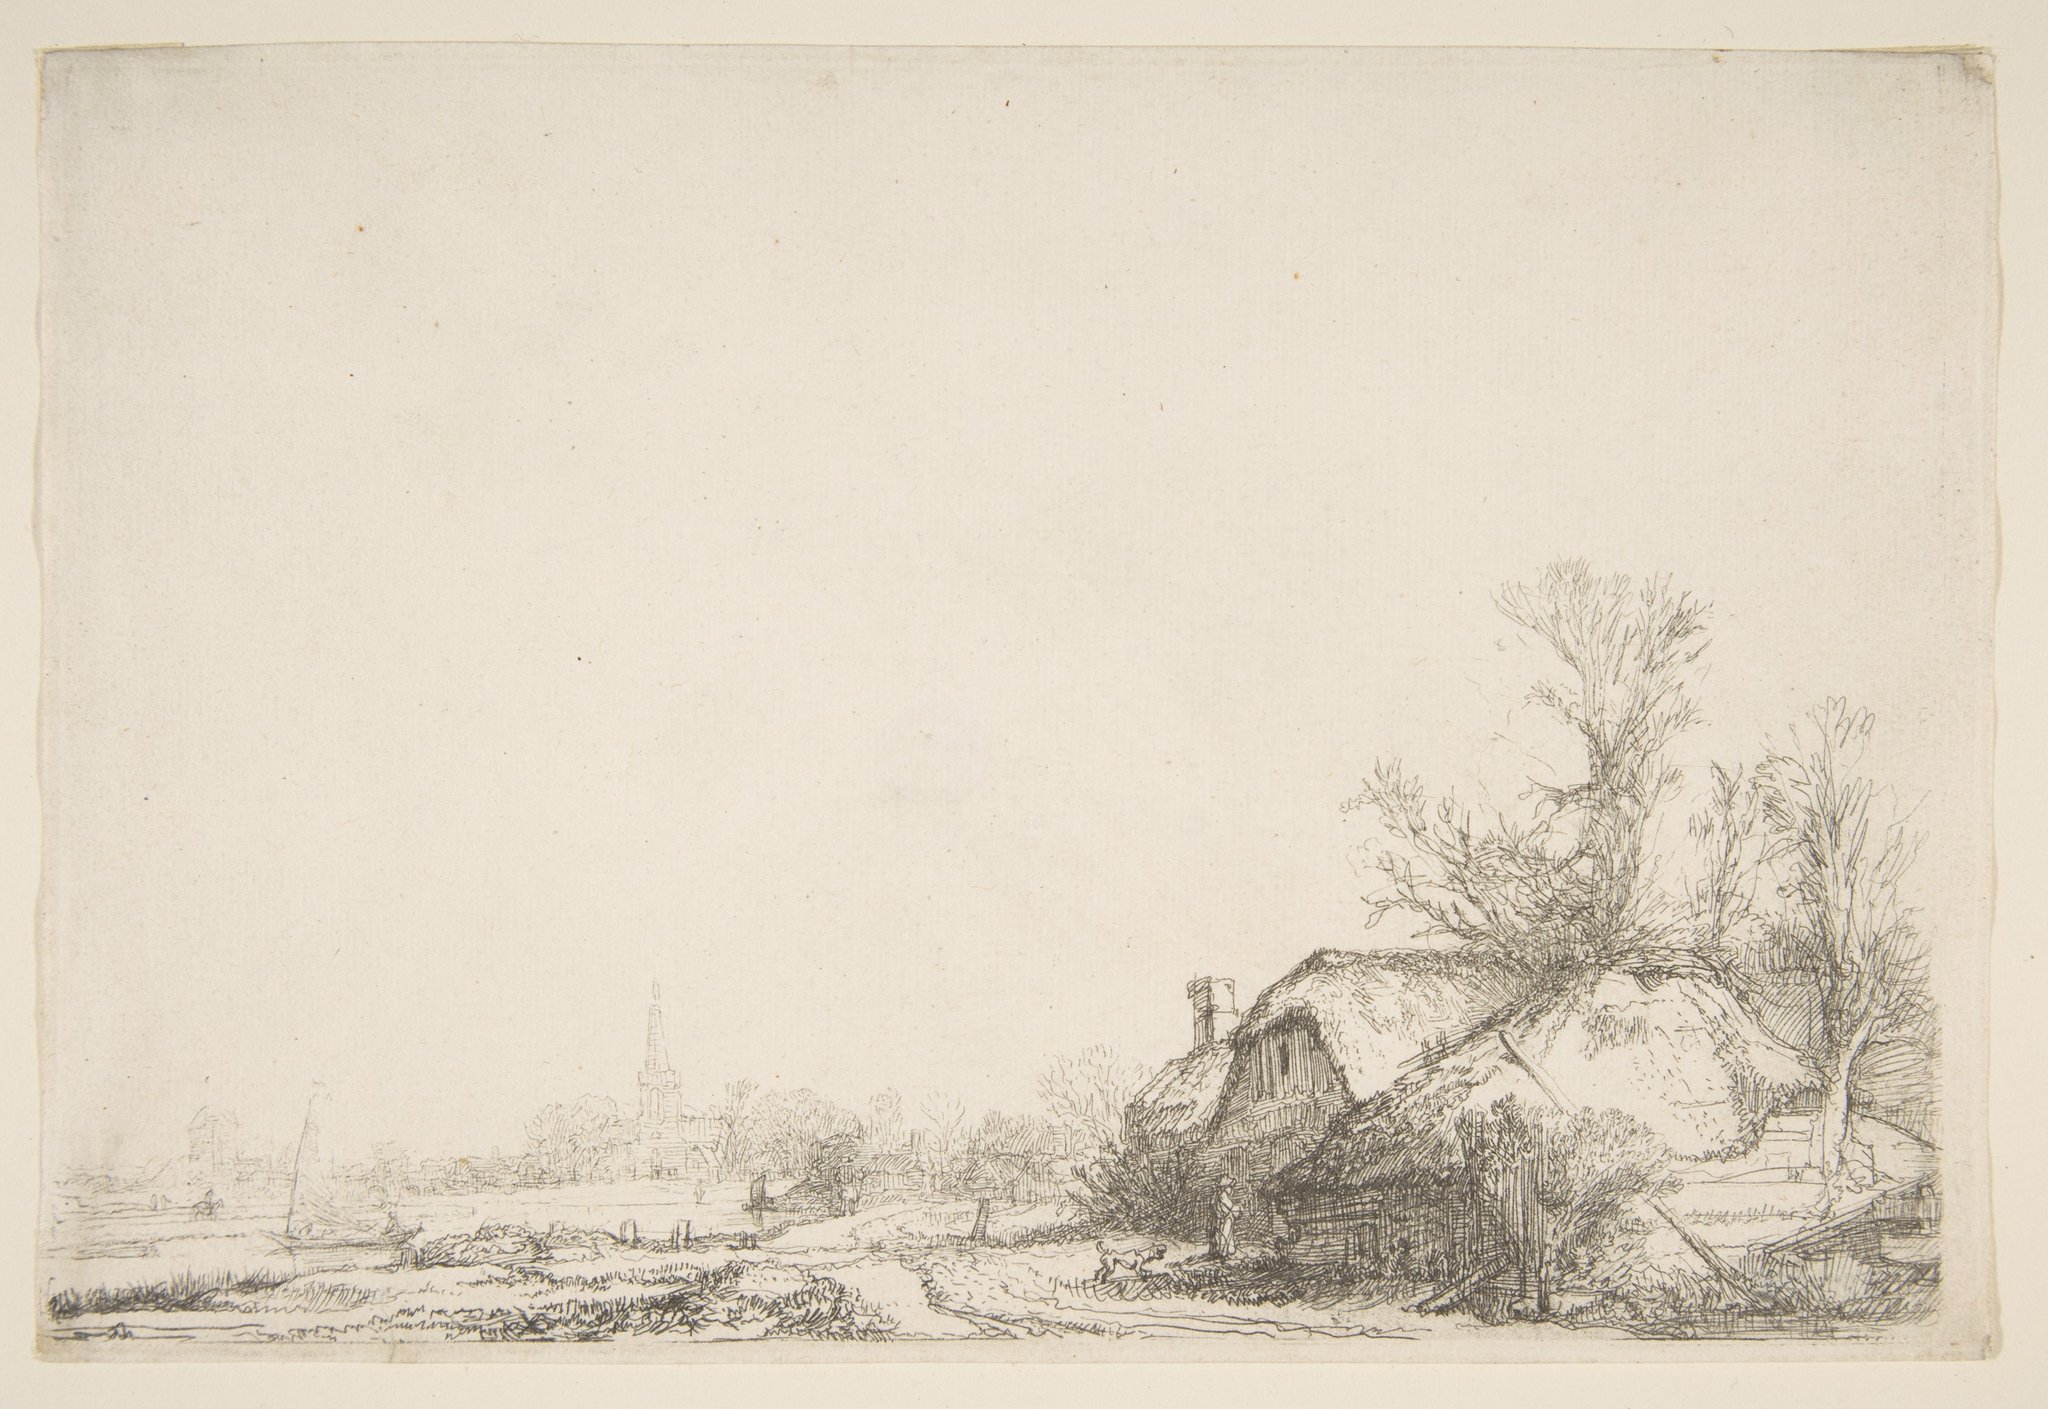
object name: print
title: Cottage Beside a Canal with a View of Ouderkerk (counterproof)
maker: rembrandt van rijn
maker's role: artist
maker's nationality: dutch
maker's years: 1606-1669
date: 1641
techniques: drypoint, etching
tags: houses,canals